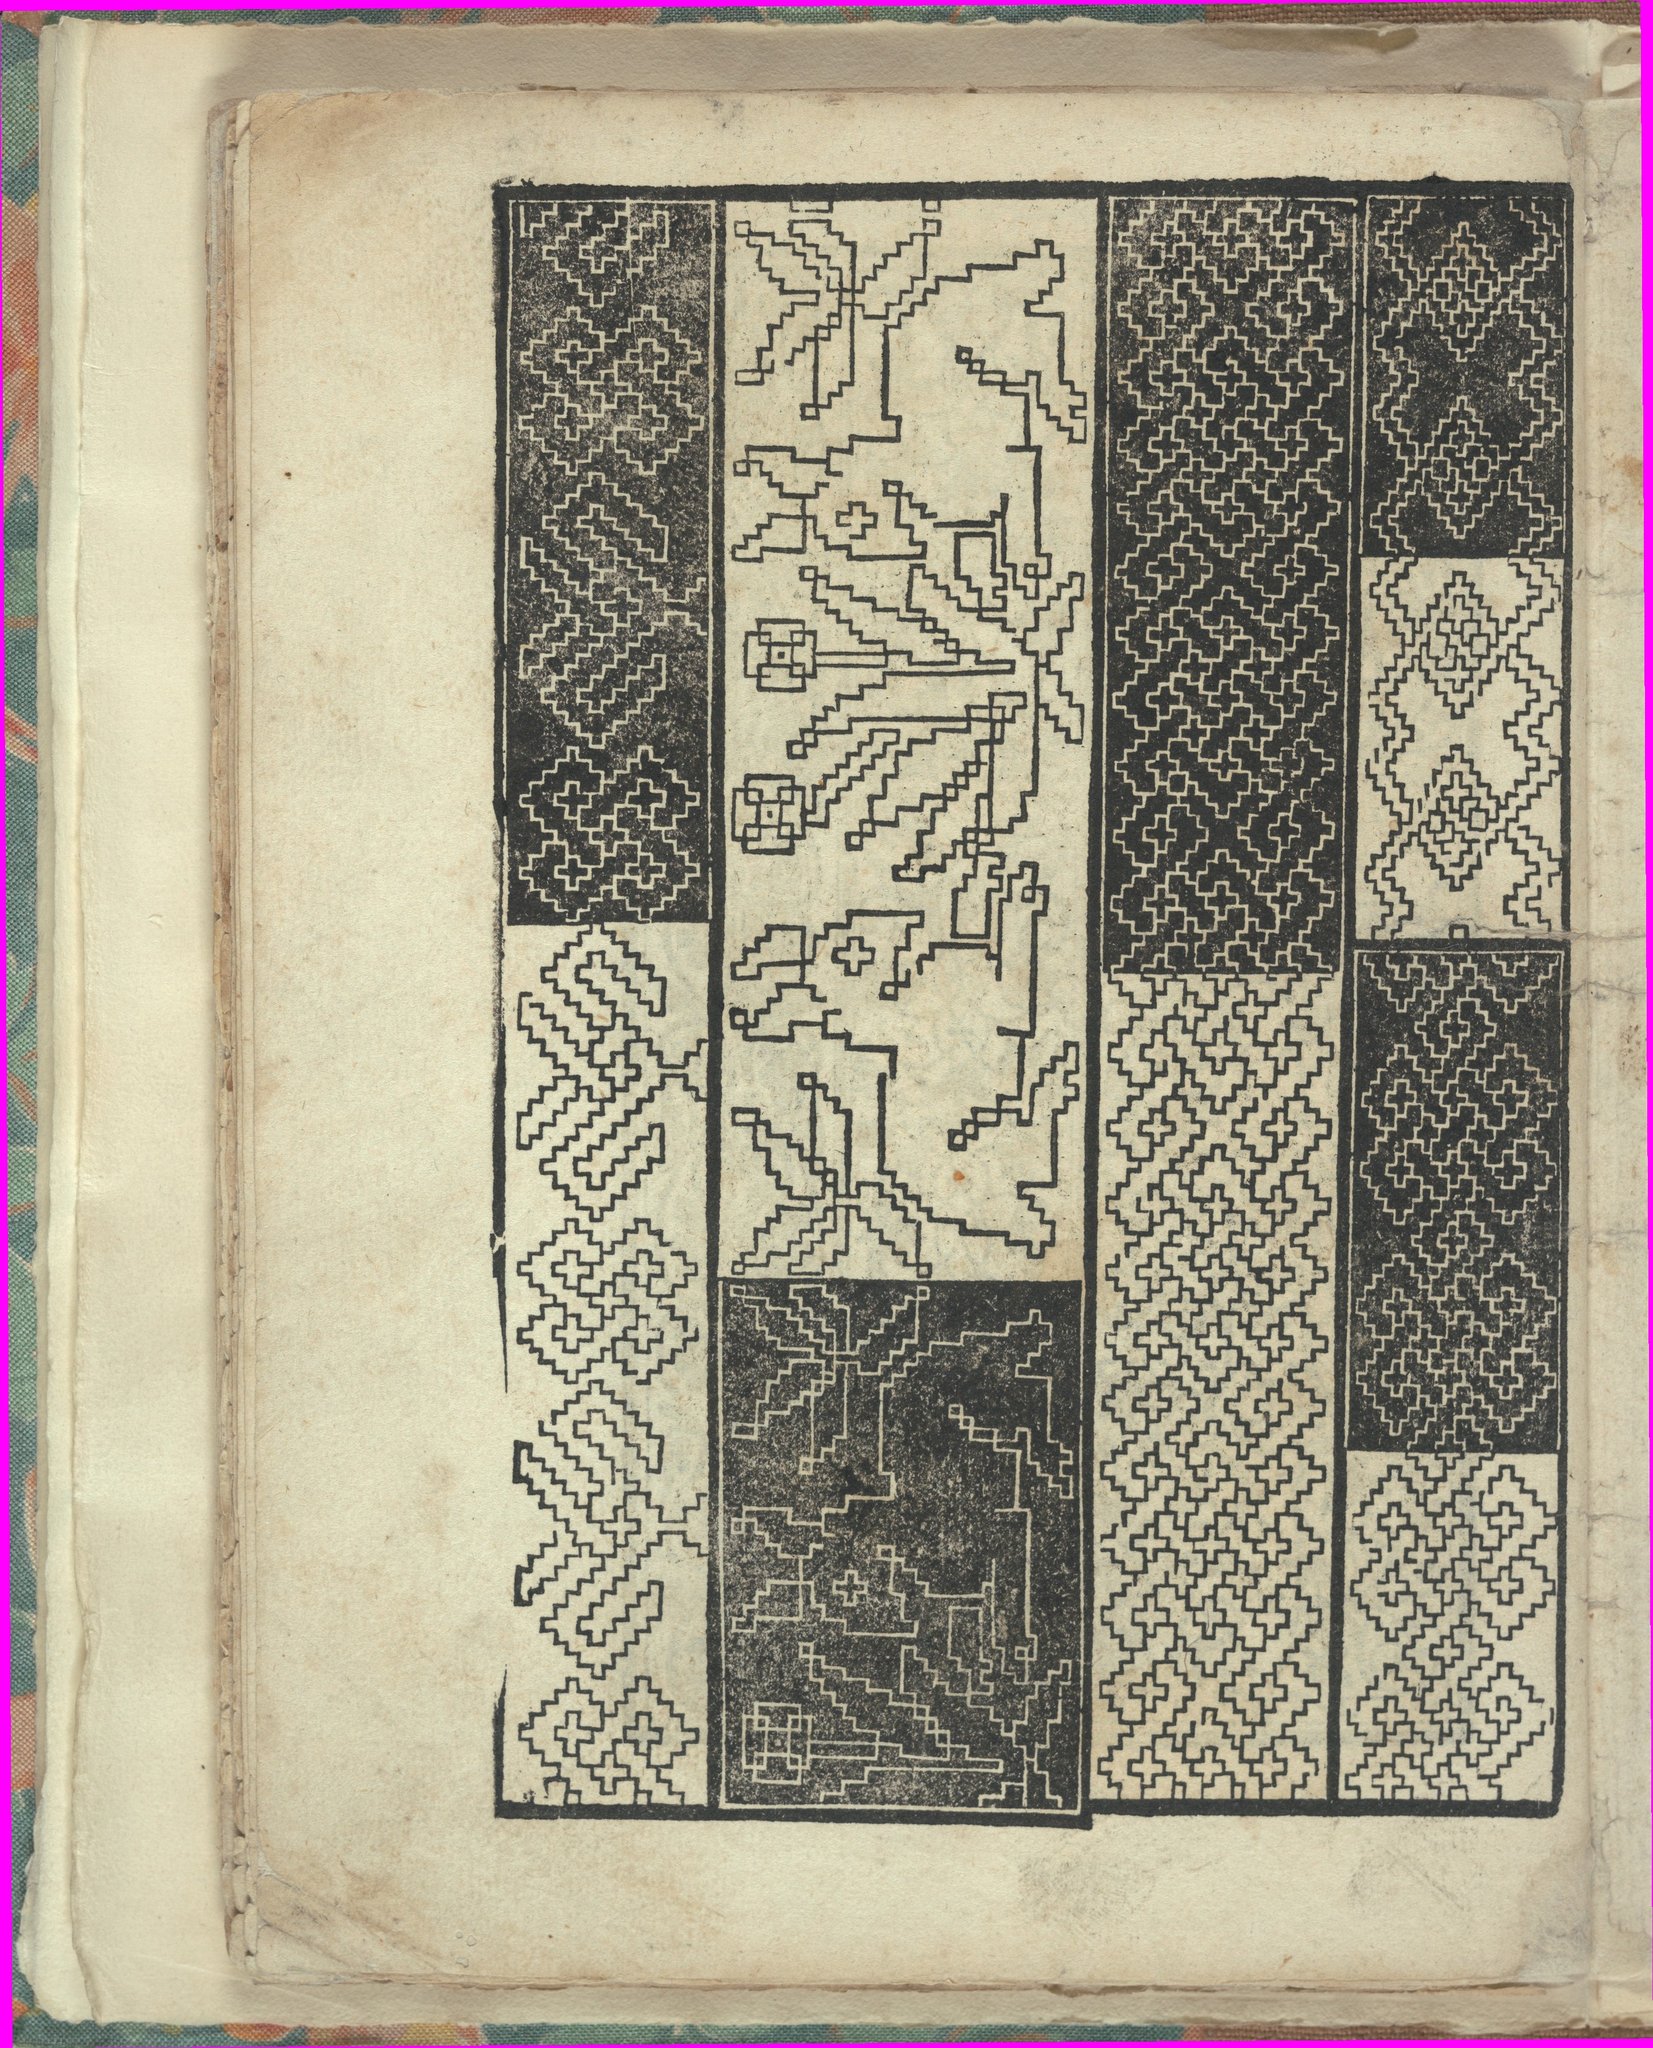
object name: book print ornament architecture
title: Opera Nova Universali intitulata Corona di racammi, page 35 (verso)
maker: giovanni andrea vavassore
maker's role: publisher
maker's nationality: italian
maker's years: 1530-1573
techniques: woodcut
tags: ornament